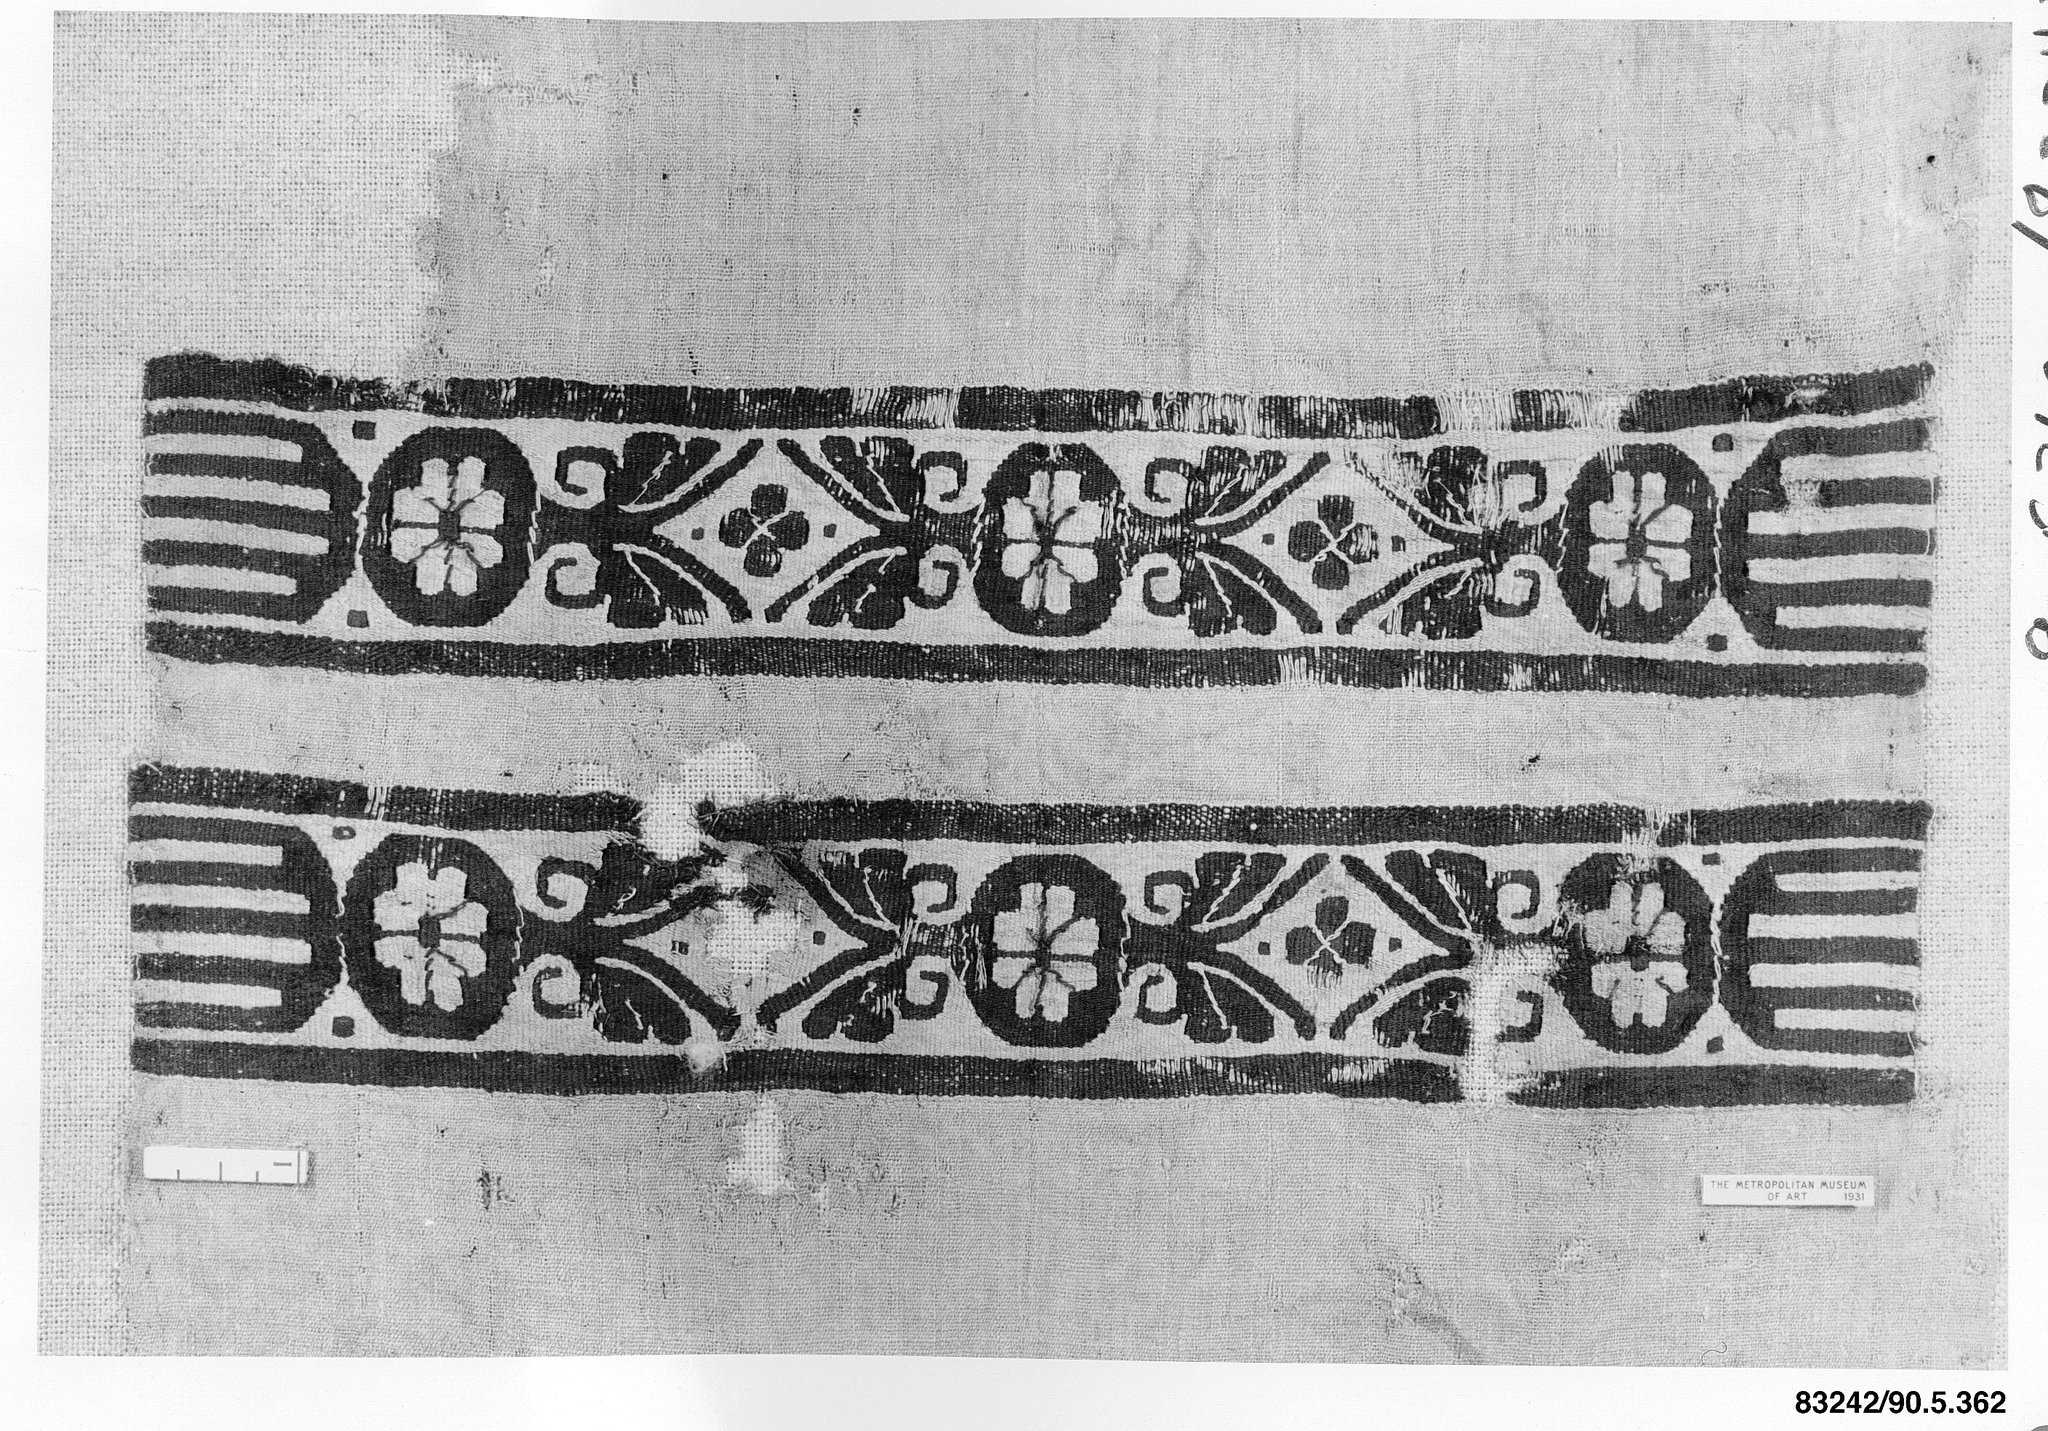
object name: textile fragment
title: Fragment of a Sleeve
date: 301-400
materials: linen, wool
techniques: weave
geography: egypt